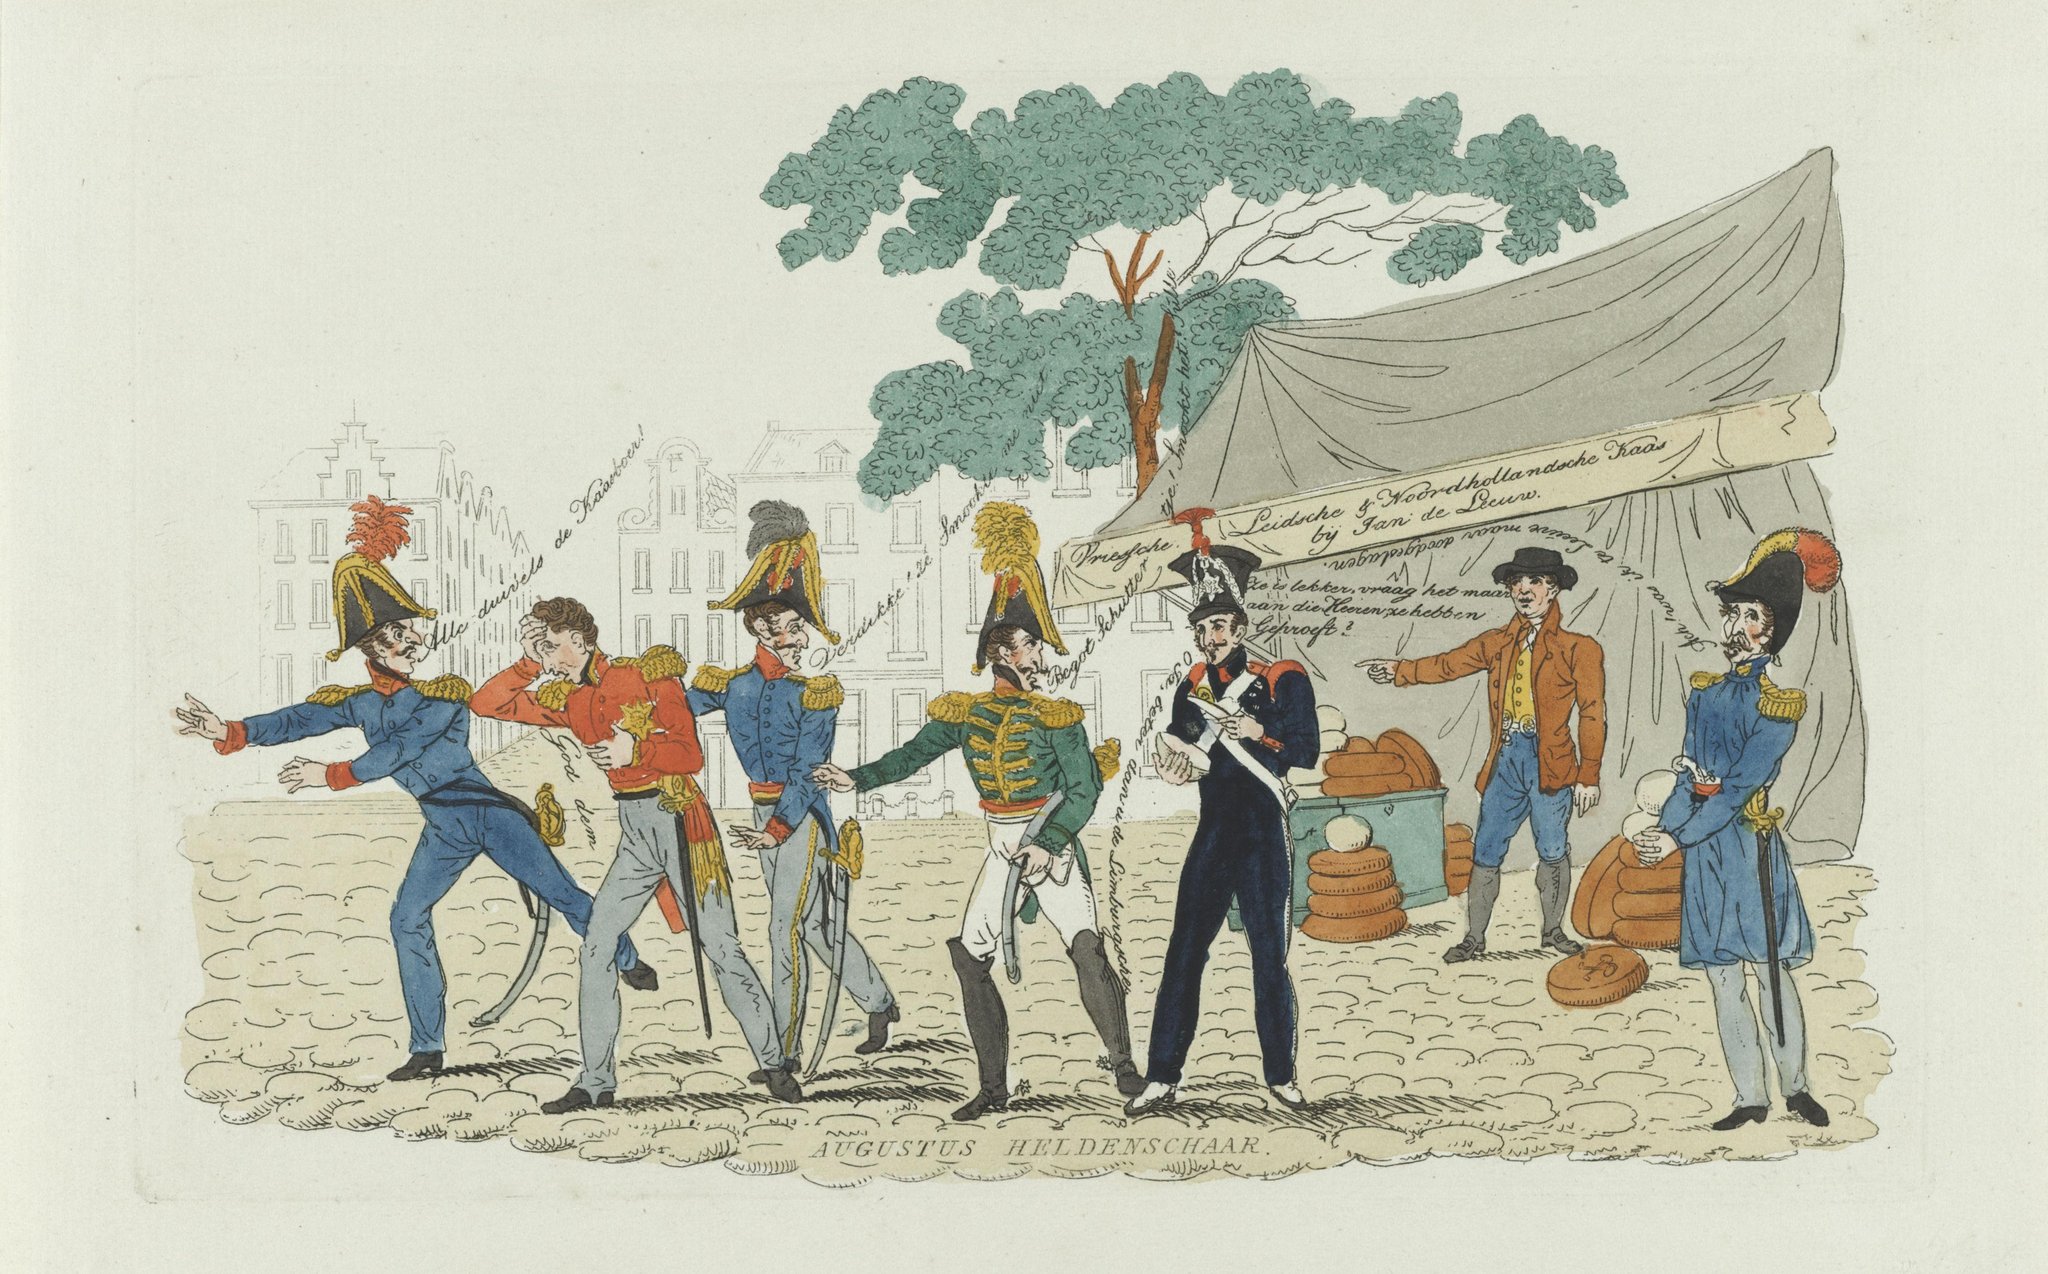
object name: print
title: Helden van augustus, 1831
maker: Anonymous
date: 1831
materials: paper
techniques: etching, hand coloring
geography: netherlands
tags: laeken, leopold i (koning der belgen), disagreeable taste, stall, booth (~ market), cheese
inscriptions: collector's mark: Lugt 2228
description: Spotprent op de Belgische nederlagen in de gevechten met de Nederlanders in augustus 1831. Koning Leopold I en zijn bondgenoten lusten de Hollandse kaas niet die zij geserveerd krijgen van een Nederlandse militair. Rechts de kraam van de Hollandse kaasboer. De figuur geheel rechts is mogelijk generaal Daine.